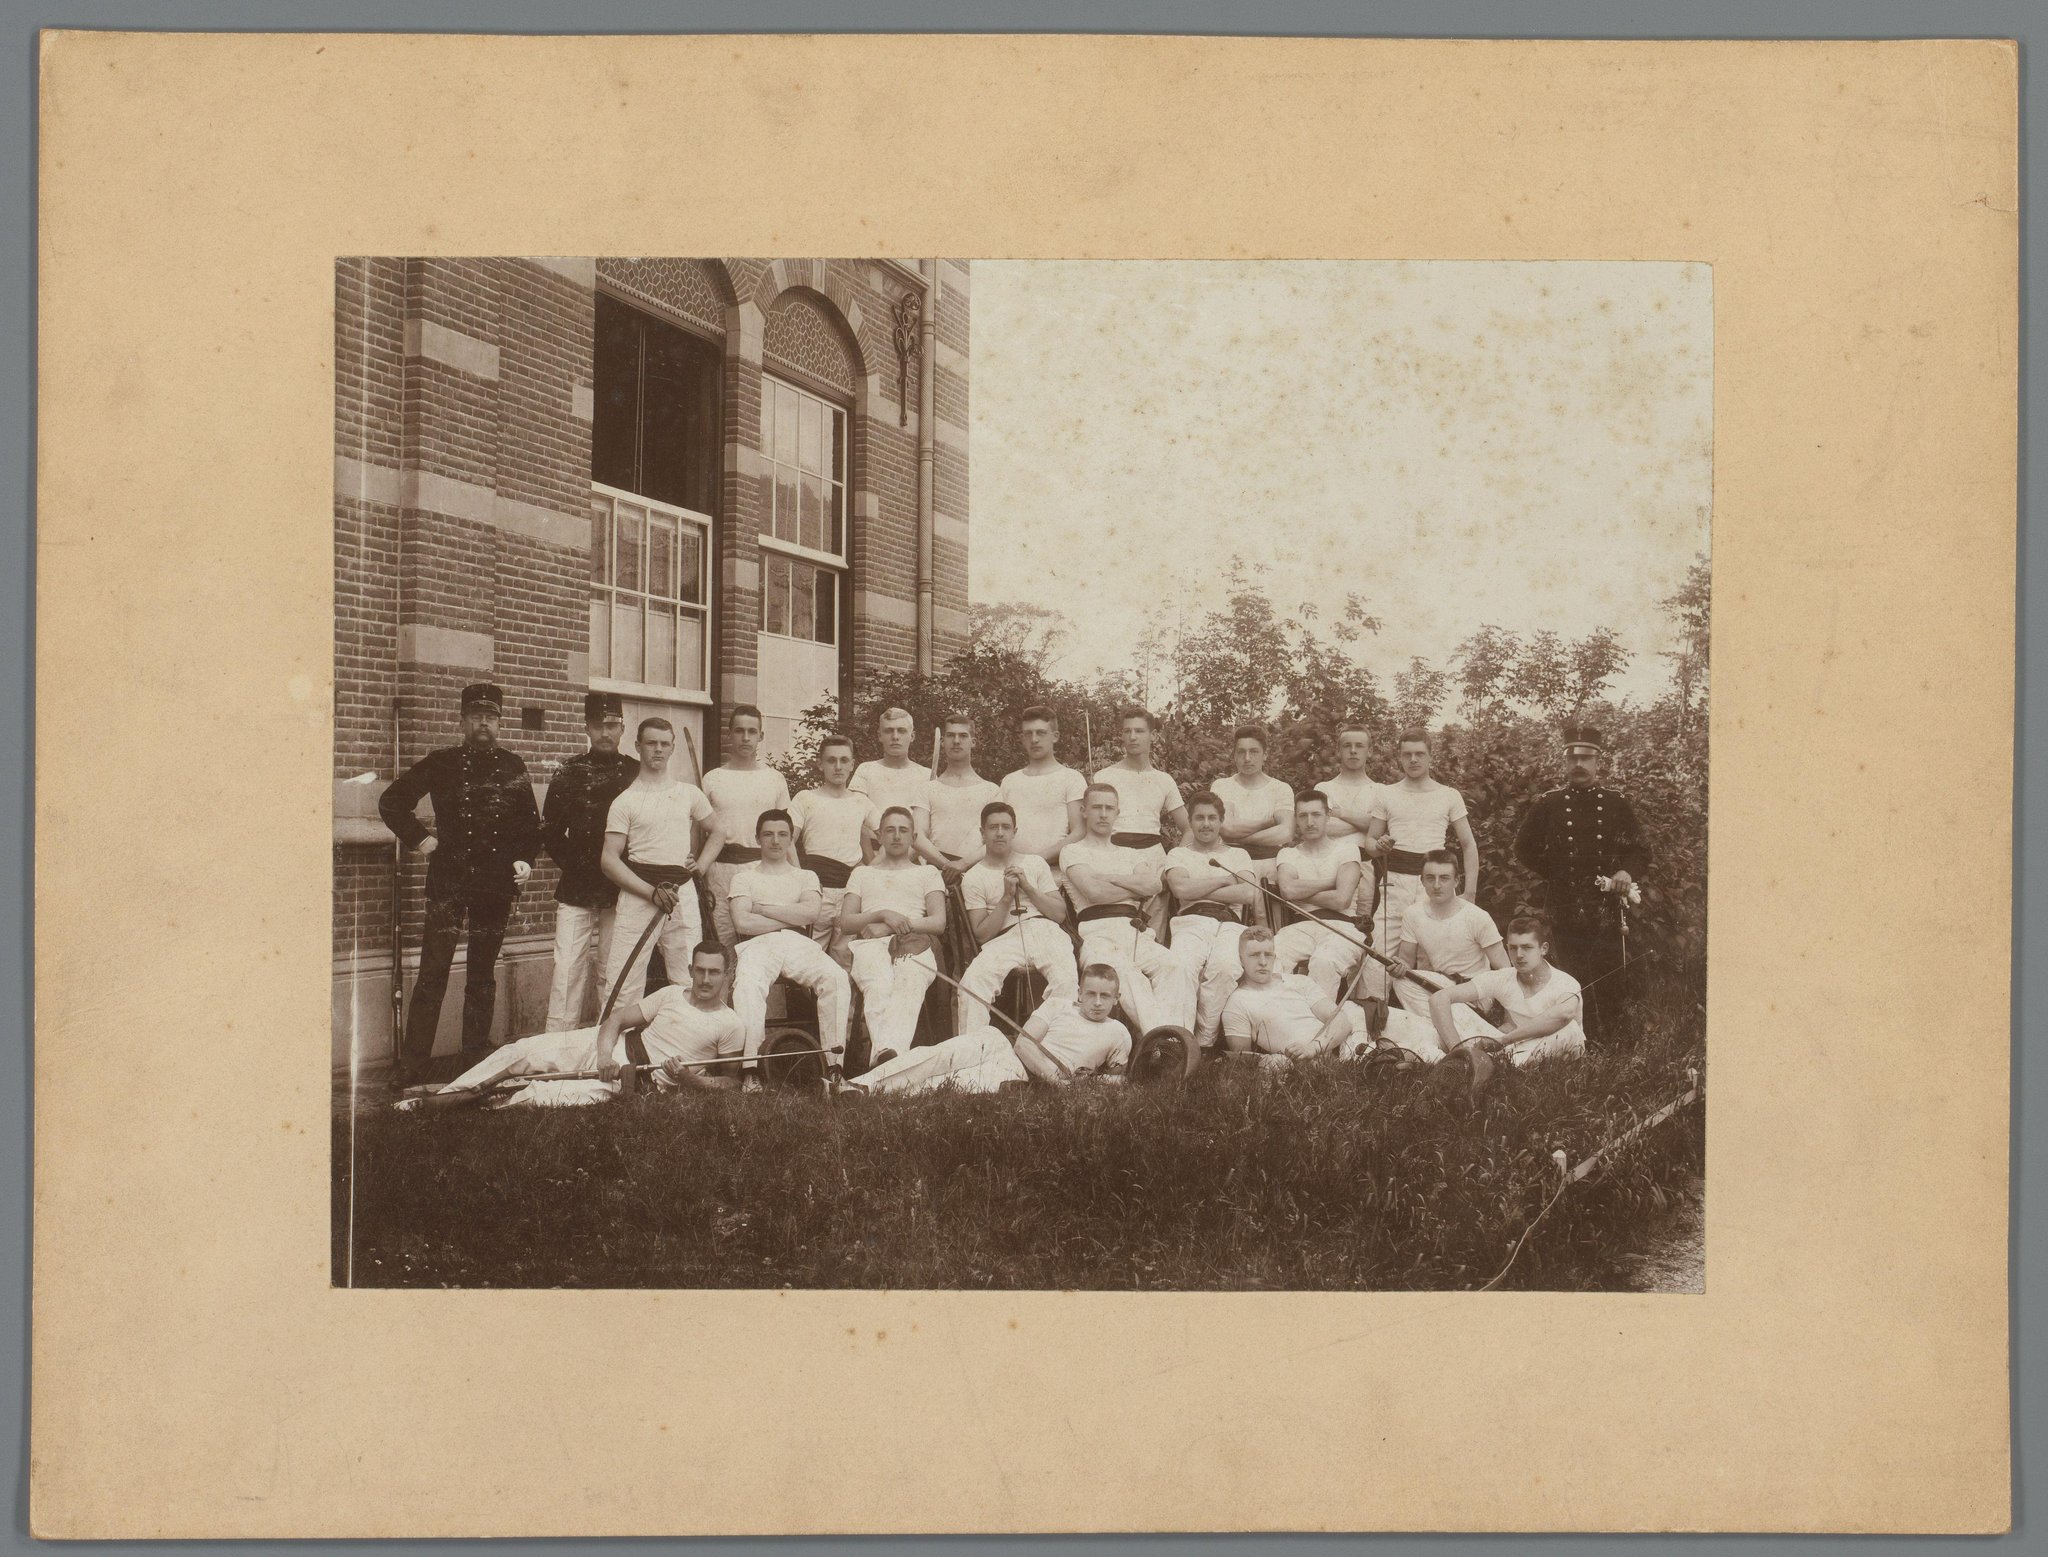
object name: photograph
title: Groepsportret van een onbekende groep militairen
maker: camillus franciscus van der aa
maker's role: painter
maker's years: 1847-1915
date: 1880-1915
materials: paper, cardboard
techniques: collodion silver print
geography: alkmaar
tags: sabre (~ fencing), the company, the unit, the troop ~ military service, anonymous historical persons portrayed in a group, in a group-portrait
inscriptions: stamp: ‘C. van der AA/ Hof-Photograaf/ Langestraat A 30/ Alkmaar.’